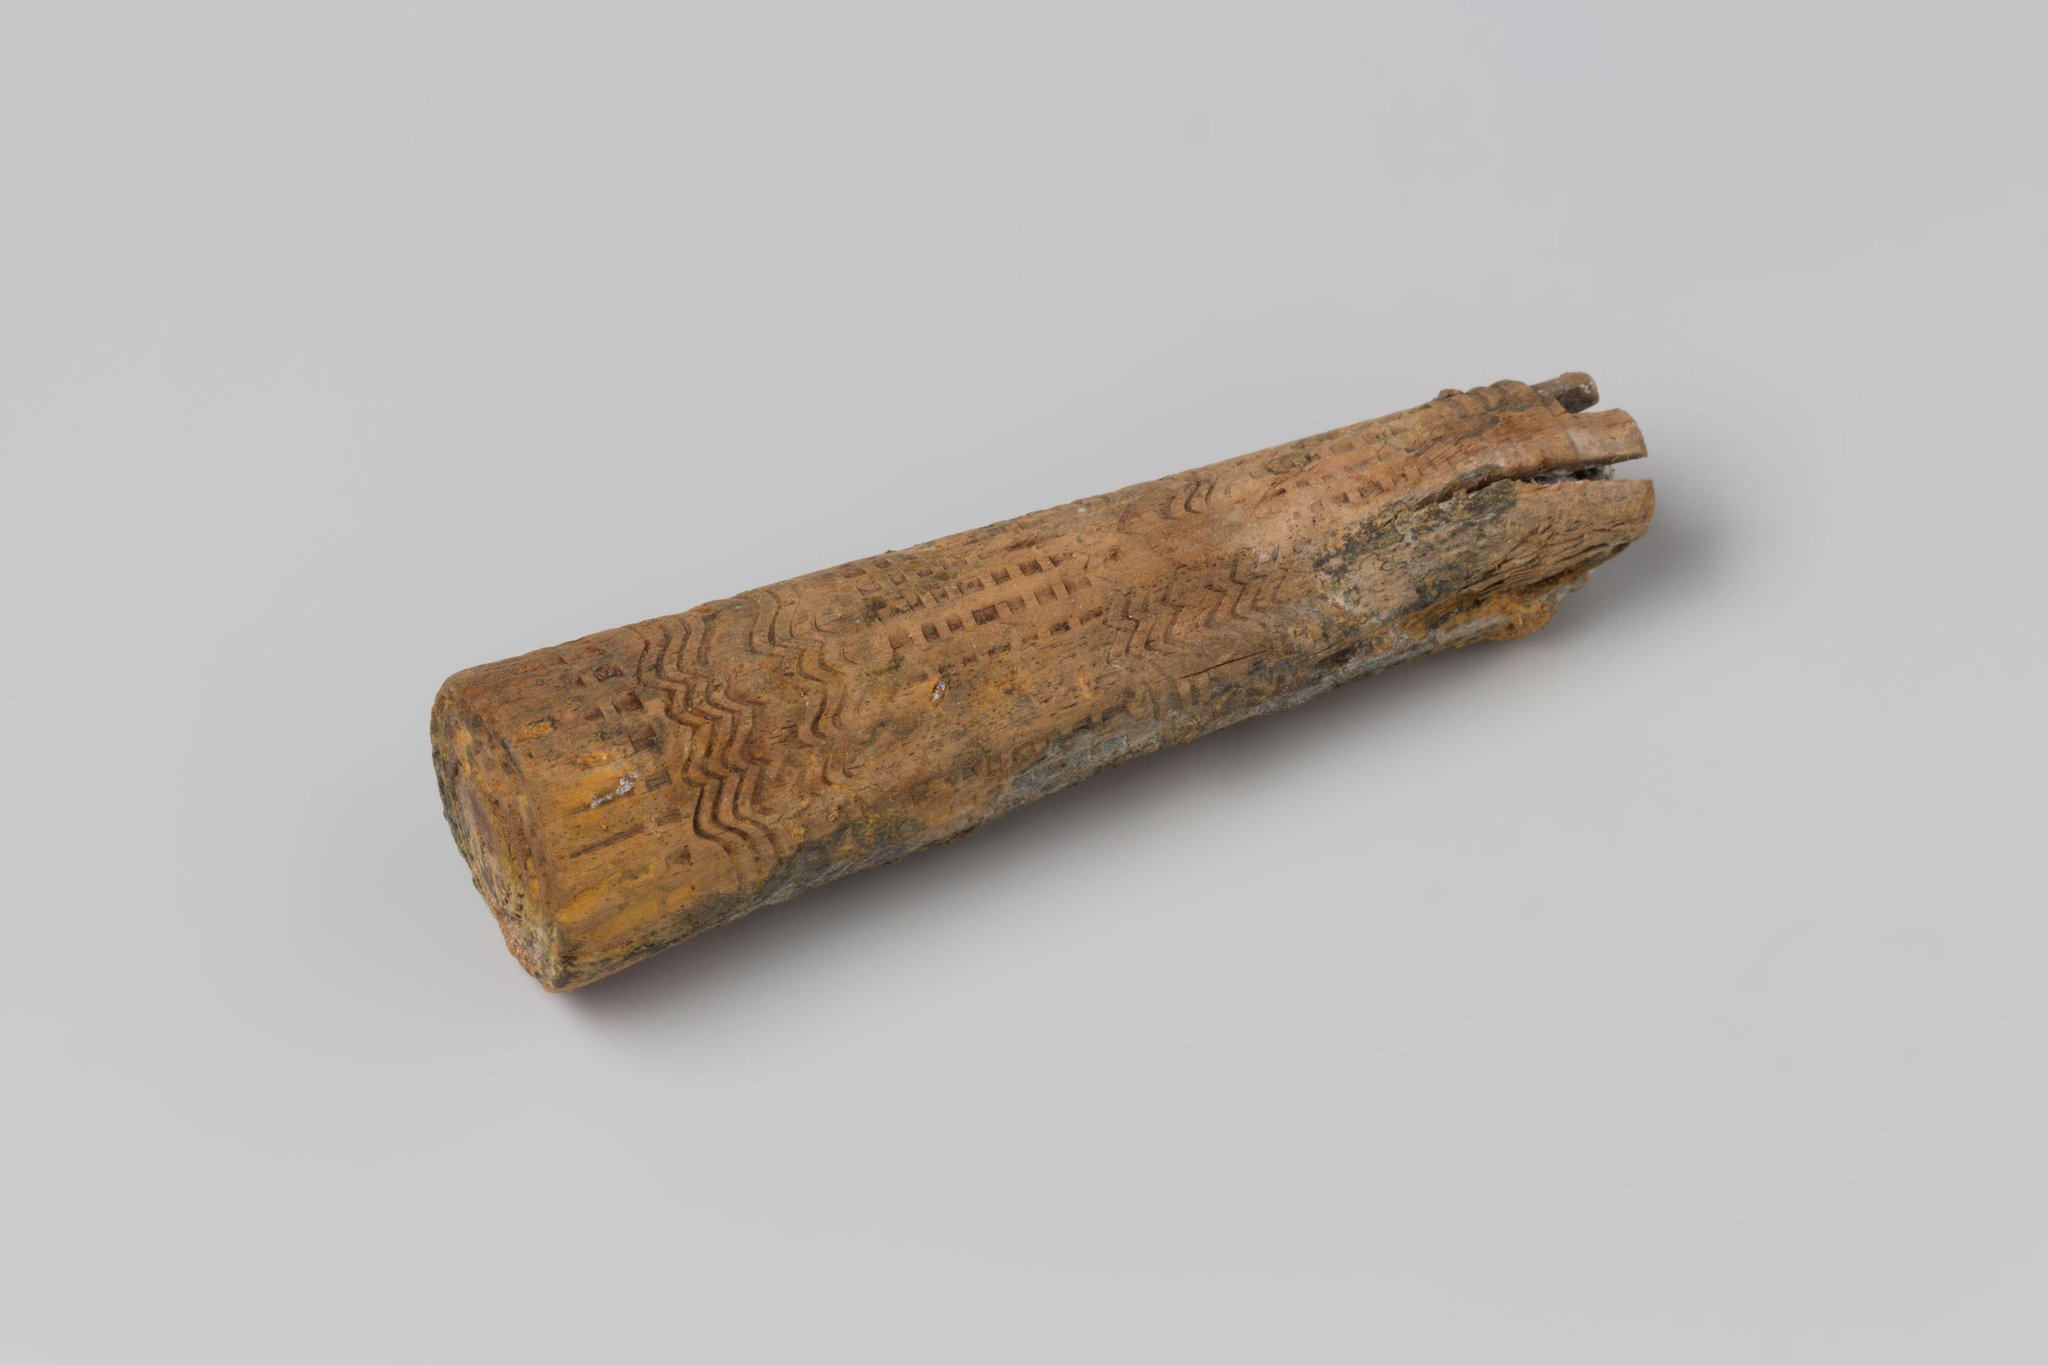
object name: knife handle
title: Messenheft uit het wrak van de Oost-Indiëvaarder Hollandia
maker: Anonymous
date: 1700-1743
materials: wood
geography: netherlands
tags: verenigde oostindische compagnie, hollandia (schip), annet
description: Knife, handle, cylindrical: tapering; id. NG 1979-403H.